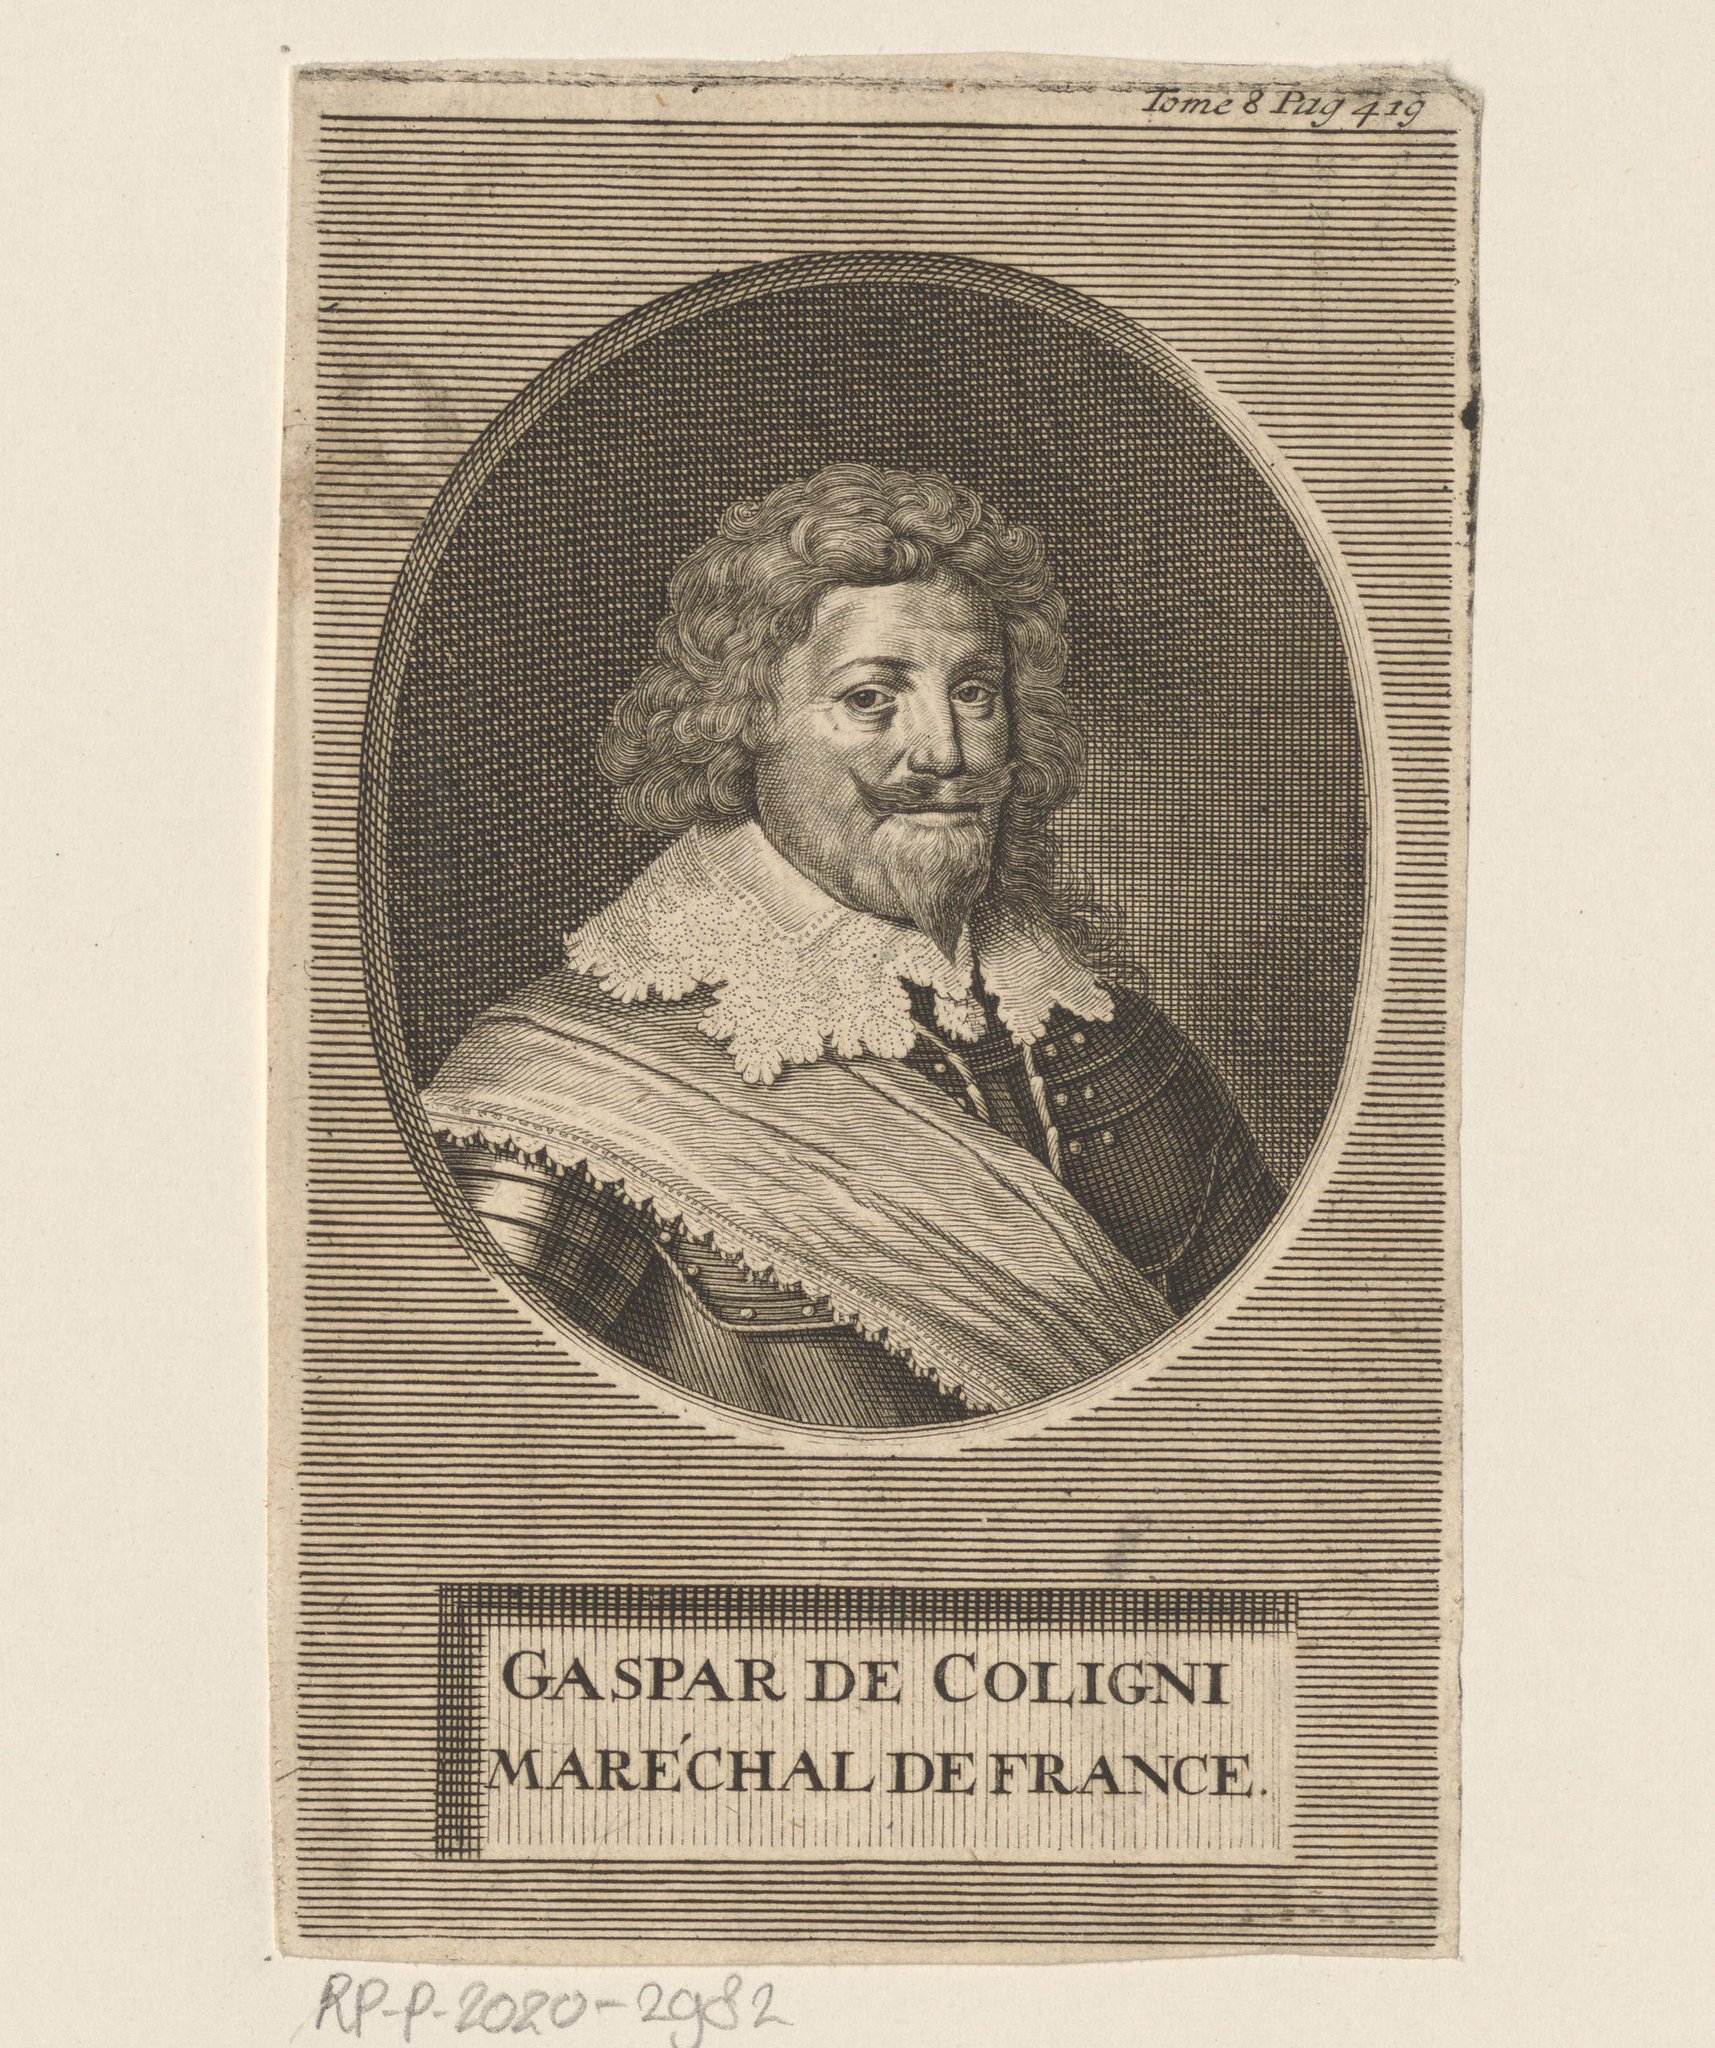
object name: print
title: Portret van Gaspard de Coligny III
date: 1707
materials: paper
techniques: engraving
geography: amsterdam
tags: historical persons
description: Prent mogelijk uit: Vassor, Michel le. Histoire du regne de Louis XIII. Amsterdam: Pierre Brunel, 1707.